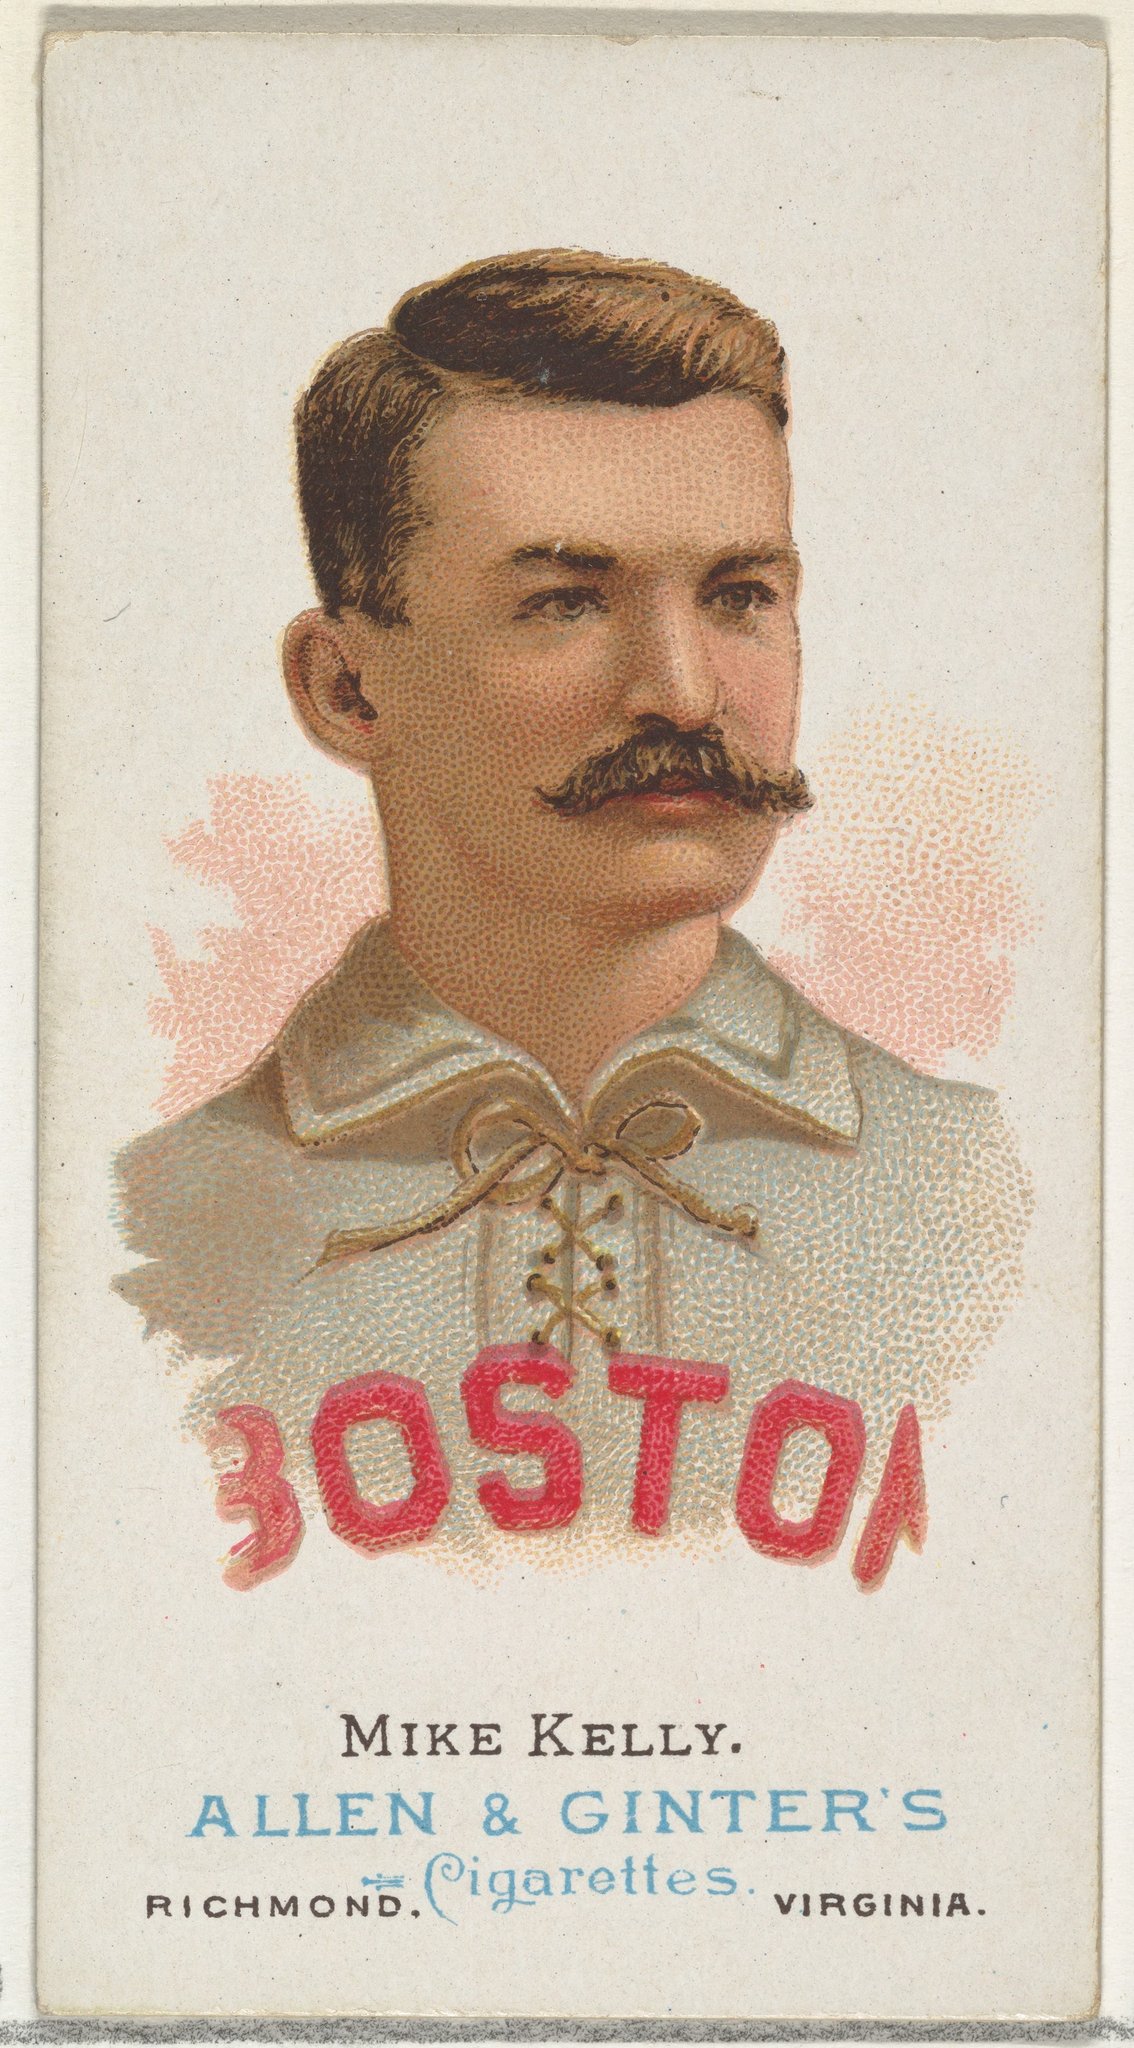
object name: baseball card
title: Mike "King" Kelly, Baseball Player, from World's Champions, Series 1 (N28) for Allen & Ginter Cigarettes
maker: allen & ginter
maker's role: publisher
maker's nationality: american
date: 1887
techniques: color lithograph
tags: men,portraits,baseball,athletes